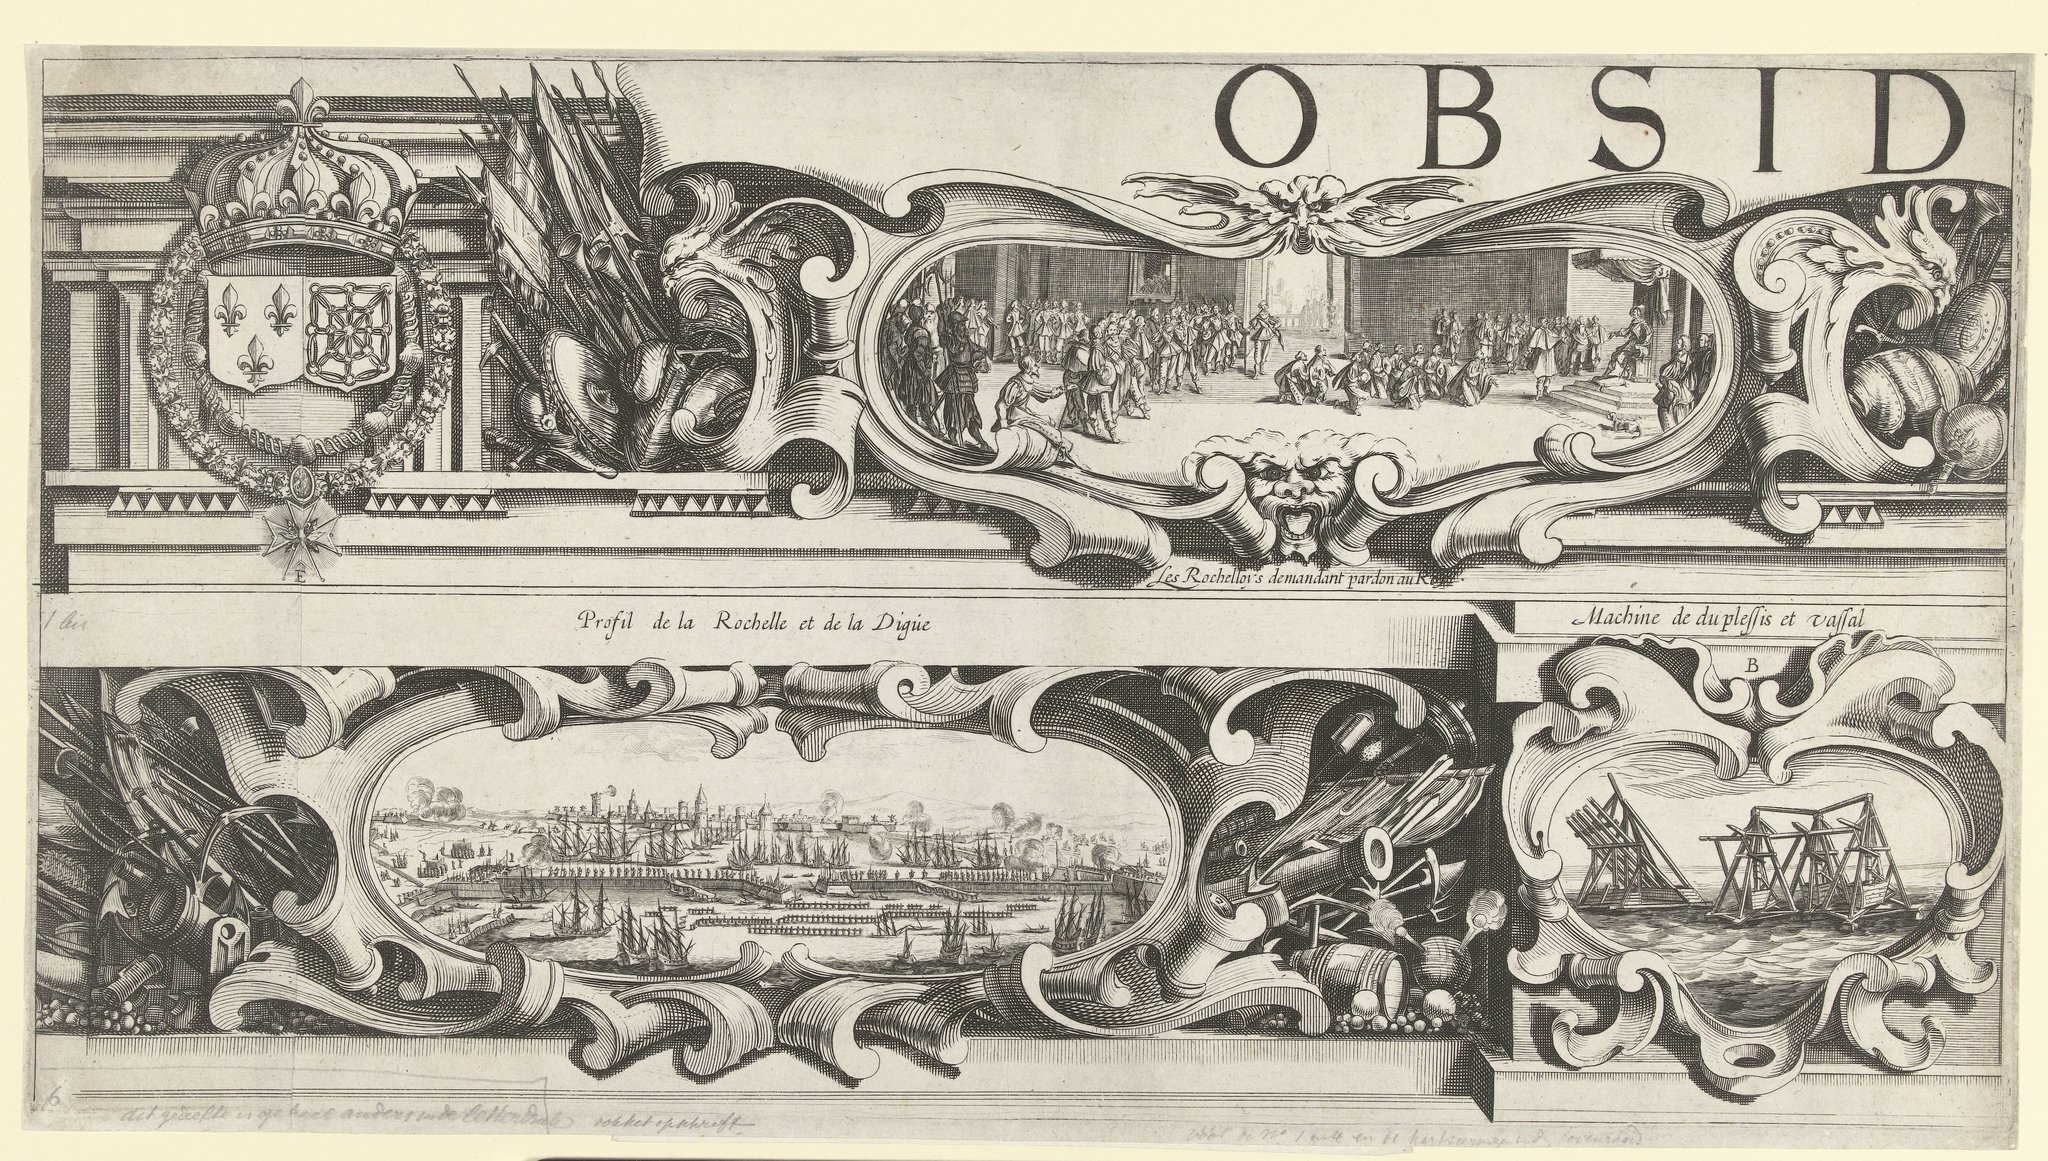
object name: print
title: Les Rochelloys demandant pardon au Roy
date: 1631-1639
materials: paper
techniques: engraving, etching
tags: paris, armand-jean du plessis hertog van richelieu, lodewijk xiii (koning van frankrijk), ornament ~ cartouche, fortified city, temporary fortifications, the defeated before the victor, armorial bearing, heraldry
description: Grote prent van het beleg van het hugenotenbolwerk La Rochelle in de jaren 1627 en 1628, dat werd uitgevoerd in opdracht van de Franse koning door het Franse leger onder aanvoering van kardinaal Richelieu. Randwerk, delen linksboven en rechtsonder op één blad (kopie). Op het bovenste deel links het wapen van Lodewijk XIII en midden/rechts een voorstelling (omgeven door militaire attributen) van bewoners van La Rochelle die de koning om genade smeken. Rechtsboven de letters 'OBSID', een deel van het opschrift van de prent. Op het onderste deel een voorstelling van een houten bouwwerk in zee en midden/links een voorstelling (omgeven door militaire attributen) van de dijk die Richelieu voor de ingang van de haven had laten bouwen om de stad af te sluiten.